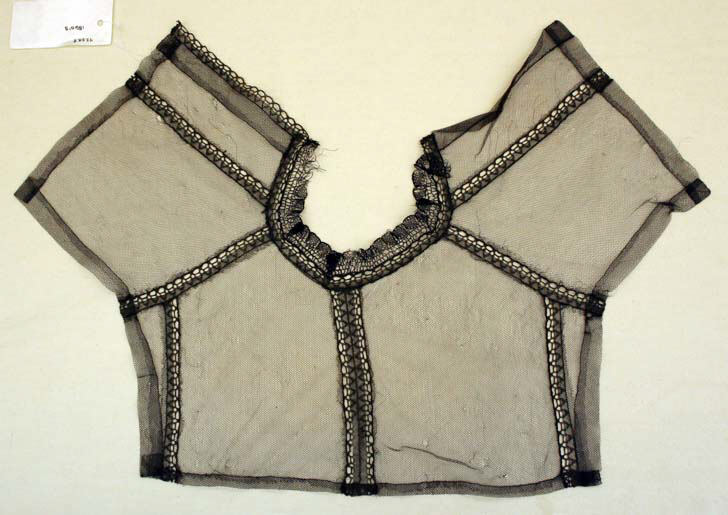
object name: vestee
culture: american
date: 1860-1869